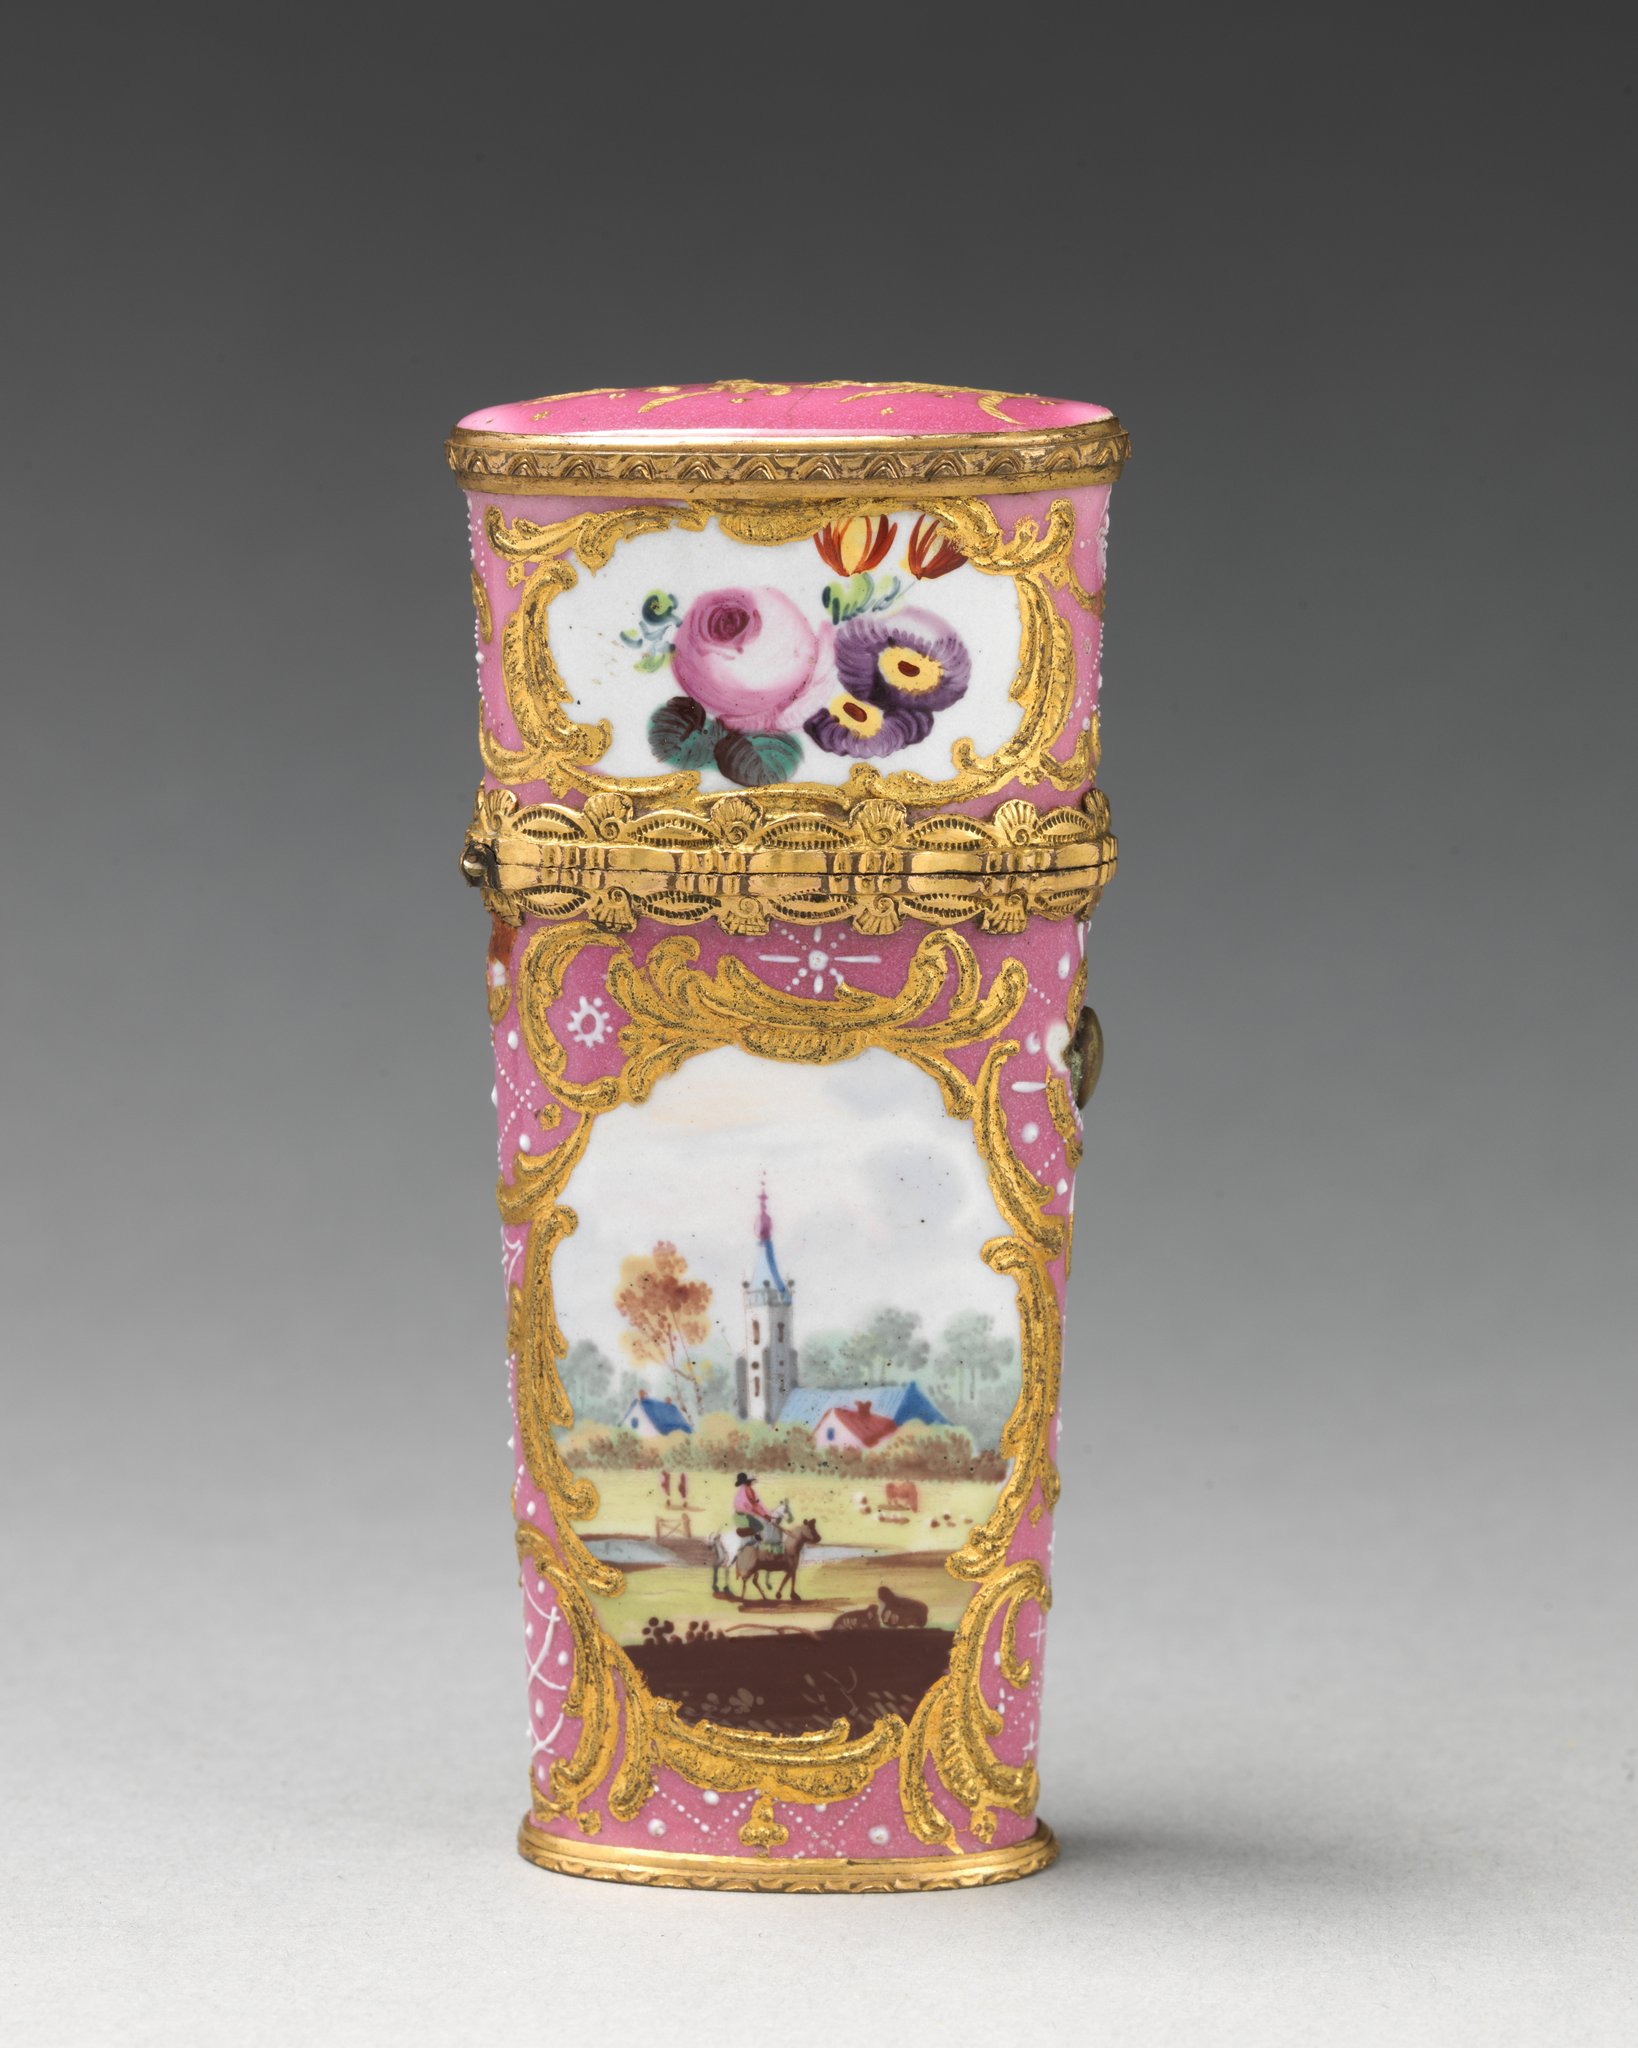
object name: étui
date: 1765-1770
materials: copper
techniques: enamel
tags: human figures,flowers,trees